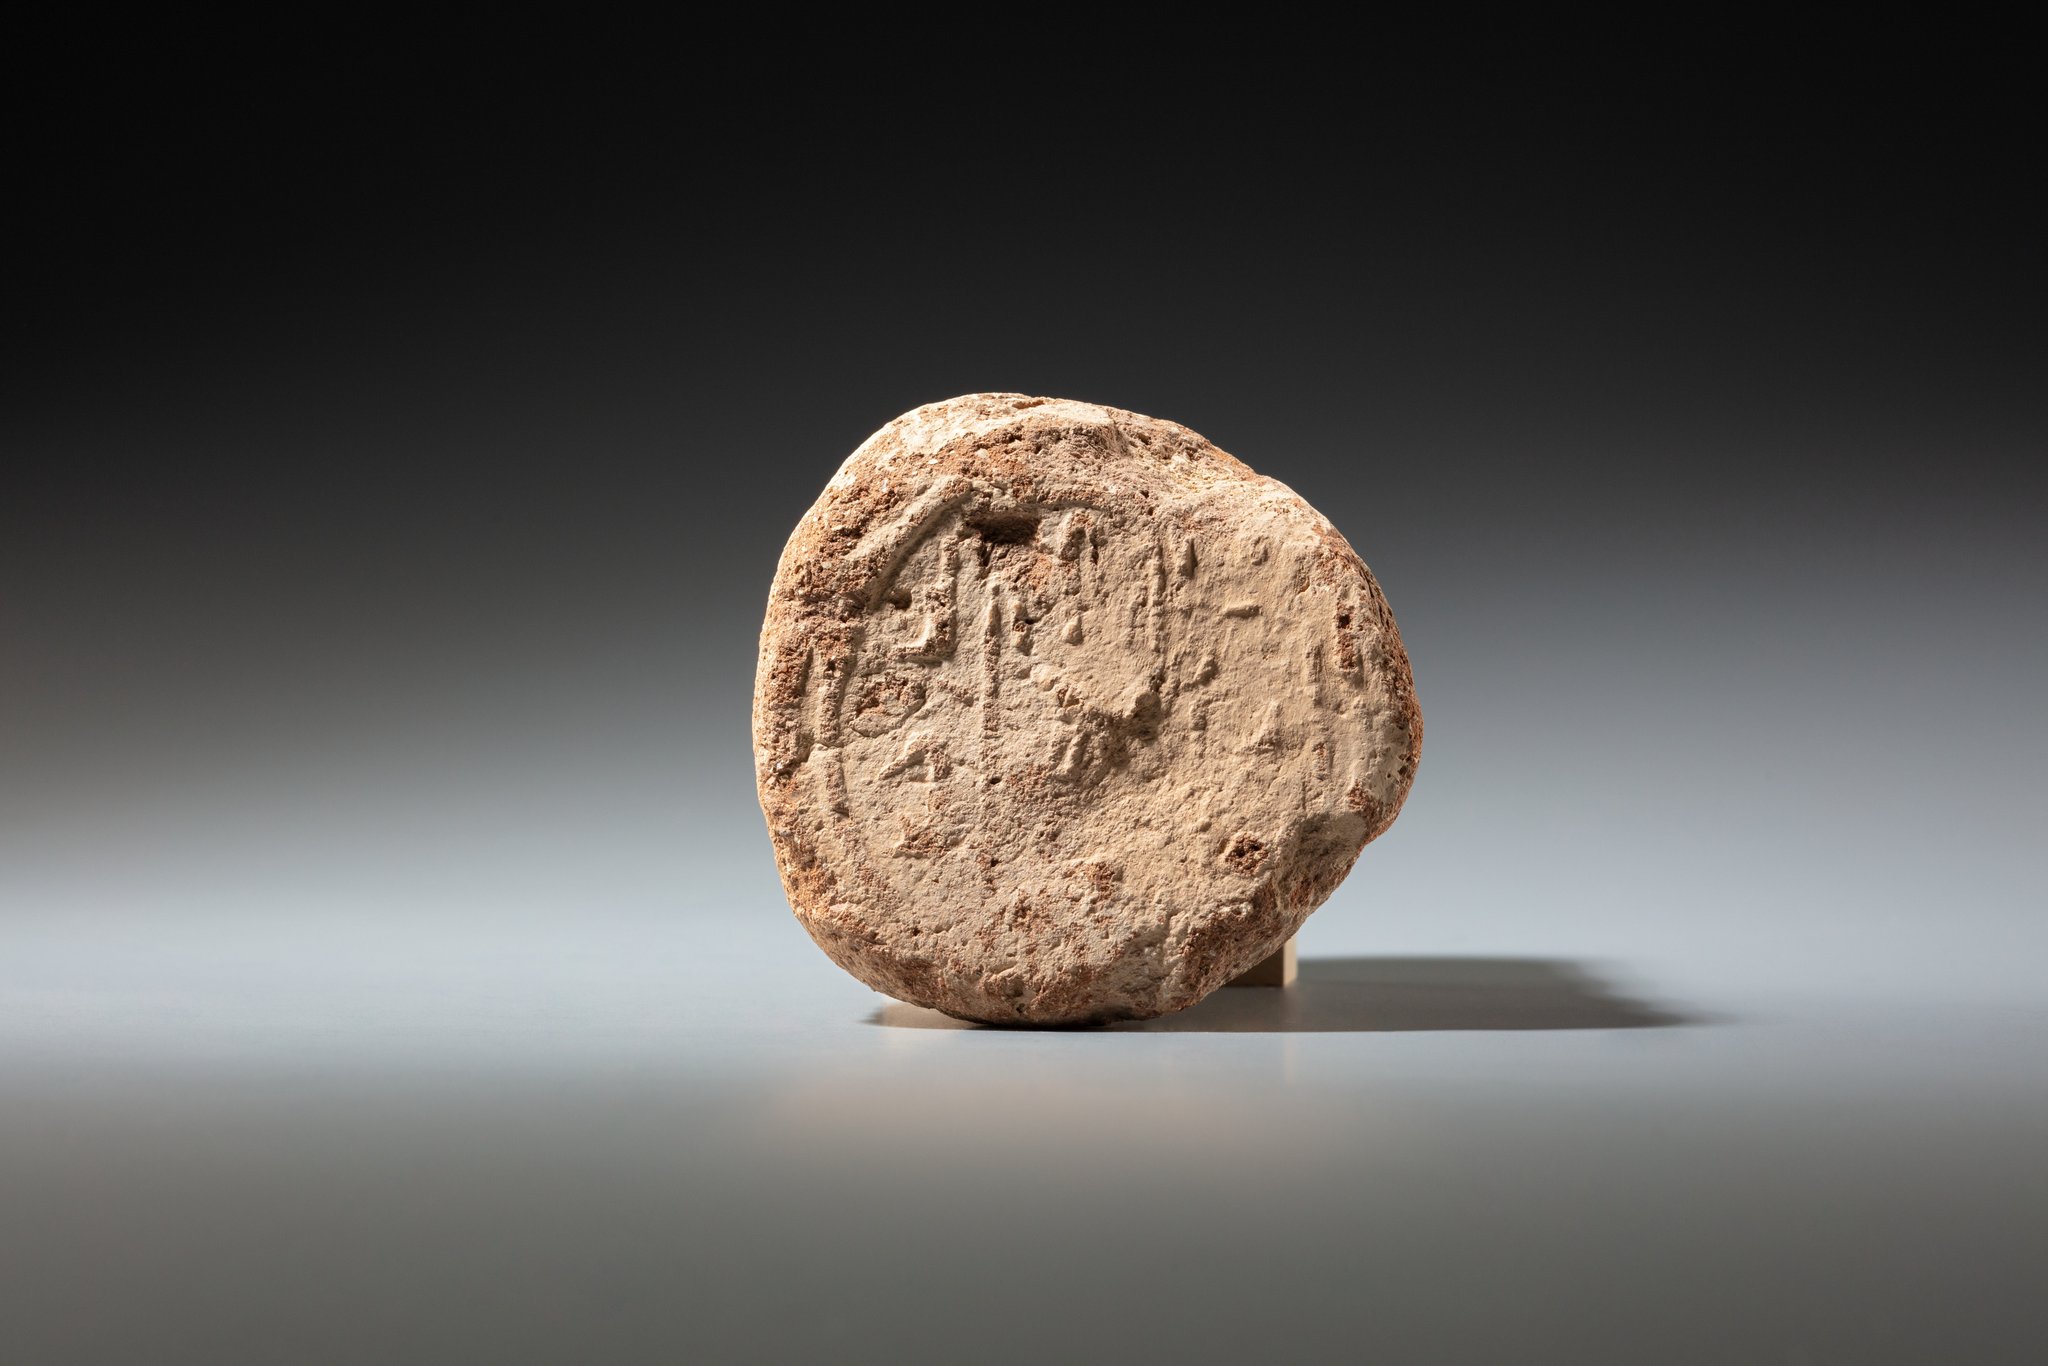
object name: cone, circle, hekaneheh, overseer of horse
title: Funerary Cone the Overseer of His Majesty's Horses Hekaneheh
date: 1550-1295 BCE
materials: pottery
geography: egypt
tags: hieroglyphs